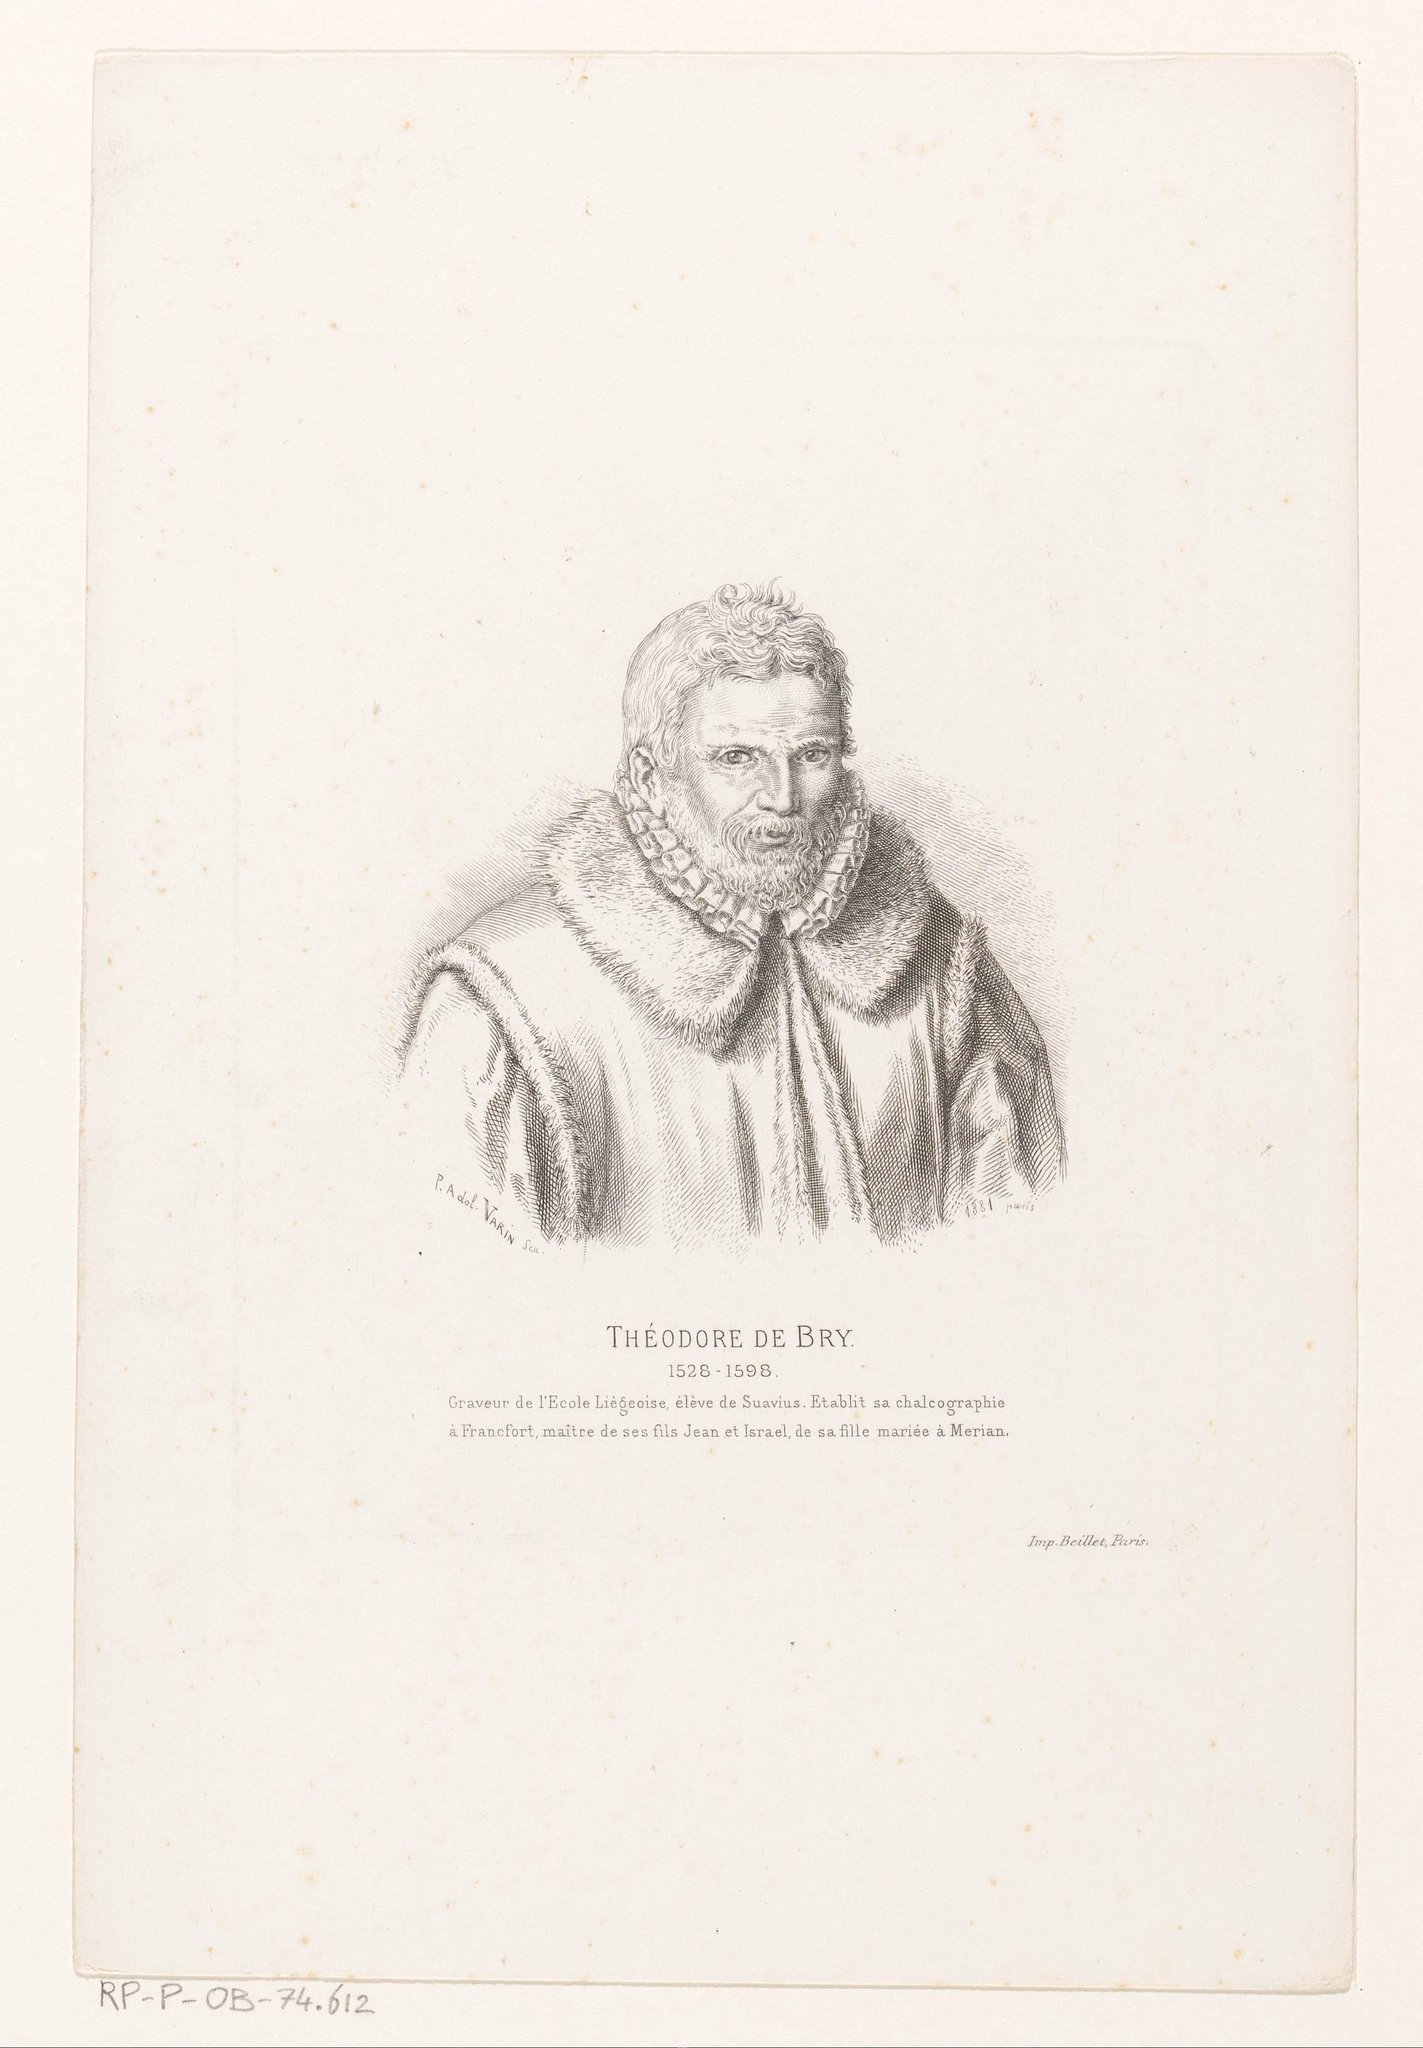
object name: print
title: Portret van Theodor de Bry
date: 1881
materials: paper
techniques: engraving, etching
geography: paris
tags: liège, print maker, draughtsman, theodor de bry, historical persons, portrait, self-portrait of artist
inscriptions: collector's mark: Lugt 2228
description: Prent uit: École liégeoise. Les Graveurs. Leurs portraits, reproduits au burin, d'après les originaux, par Adolphe Varin, 1366-1850. Avec notes historiques (...). Parijs: Fr. Gobbaerts, ca. 1684.